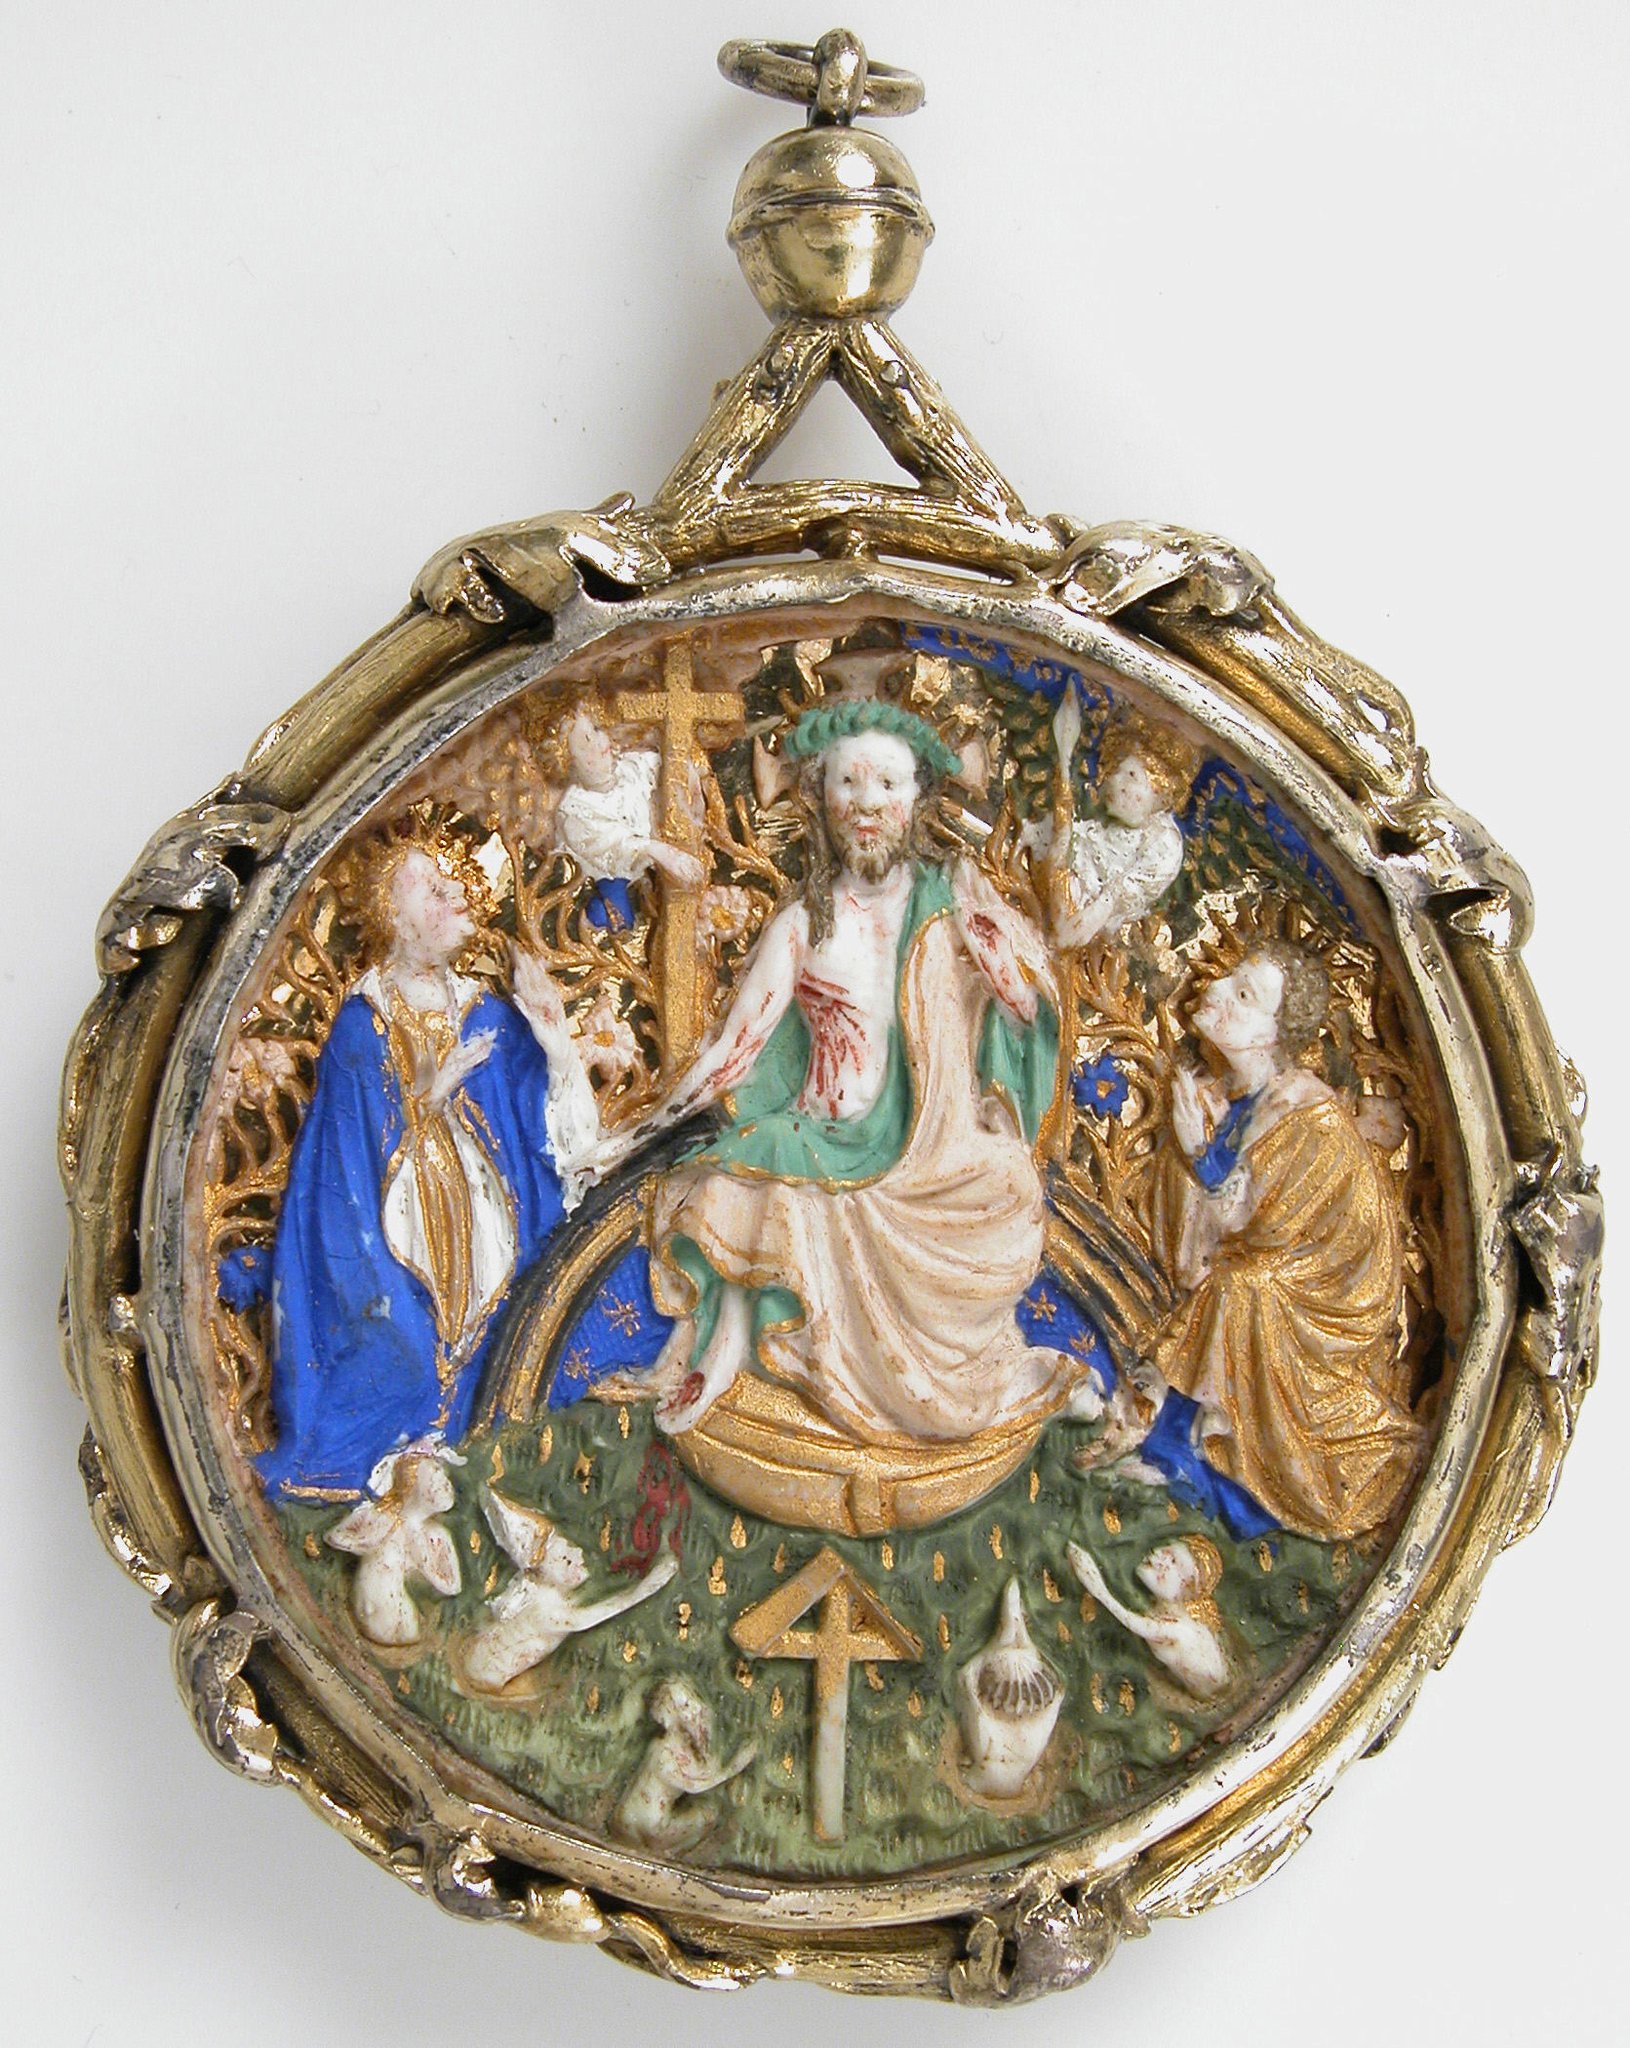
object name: medallion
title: Pendant Medallion with the Last Judgment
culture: french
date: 1420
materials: ivory, paint, silver gilt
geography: france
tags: christ,virgin mary,last judgement